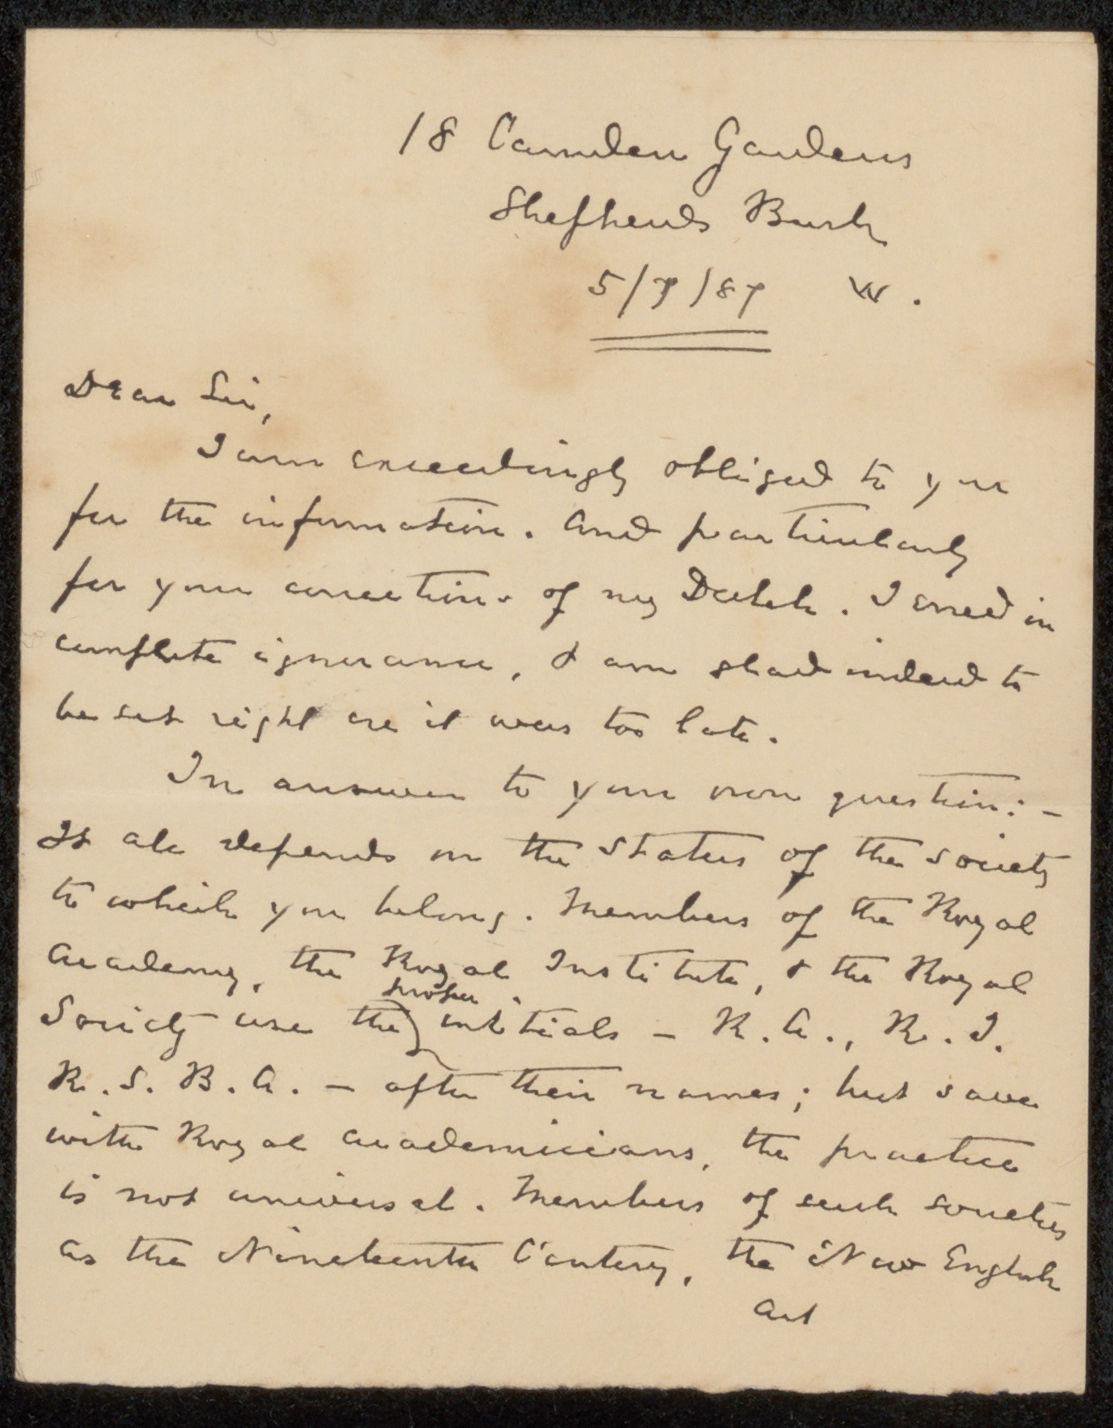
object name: letter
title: Brief aan Philip Zilcken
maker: william ernest henley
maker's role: criticus, dichter, redacteur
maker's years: 1849-1903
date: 1887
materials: ink, paper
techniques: pen, writing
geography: shepherd's bush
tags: the hague, painter, print maker, draughtsman, hendrik willem mesdag, philip zilcken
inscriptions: collector's mark: ‘RPK’